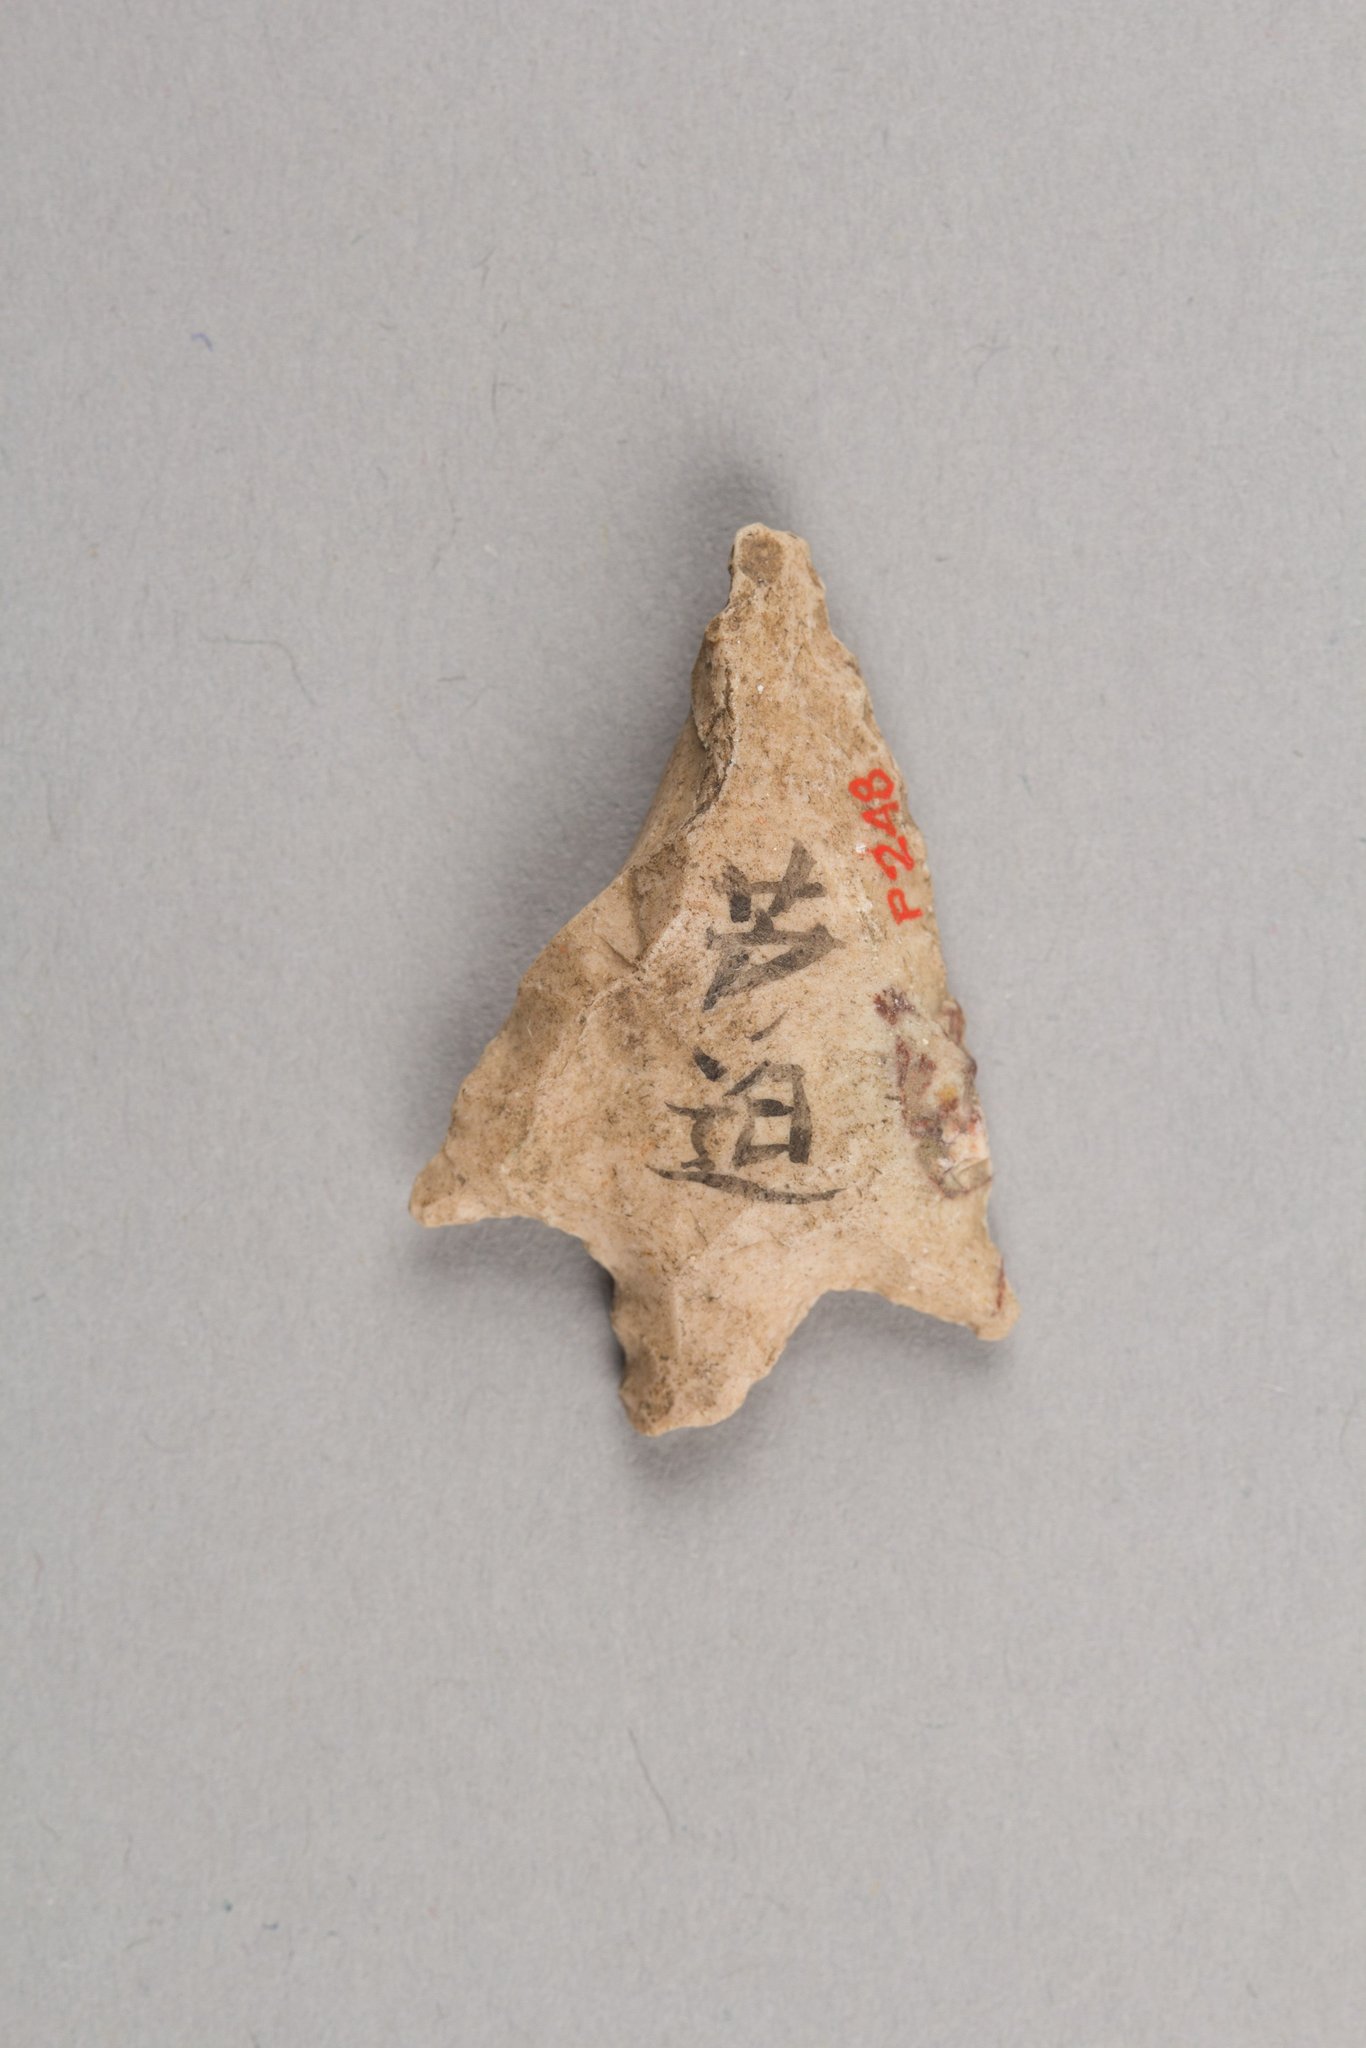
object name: arrowhead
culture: japanese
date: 1500-1000 BCE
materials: stone